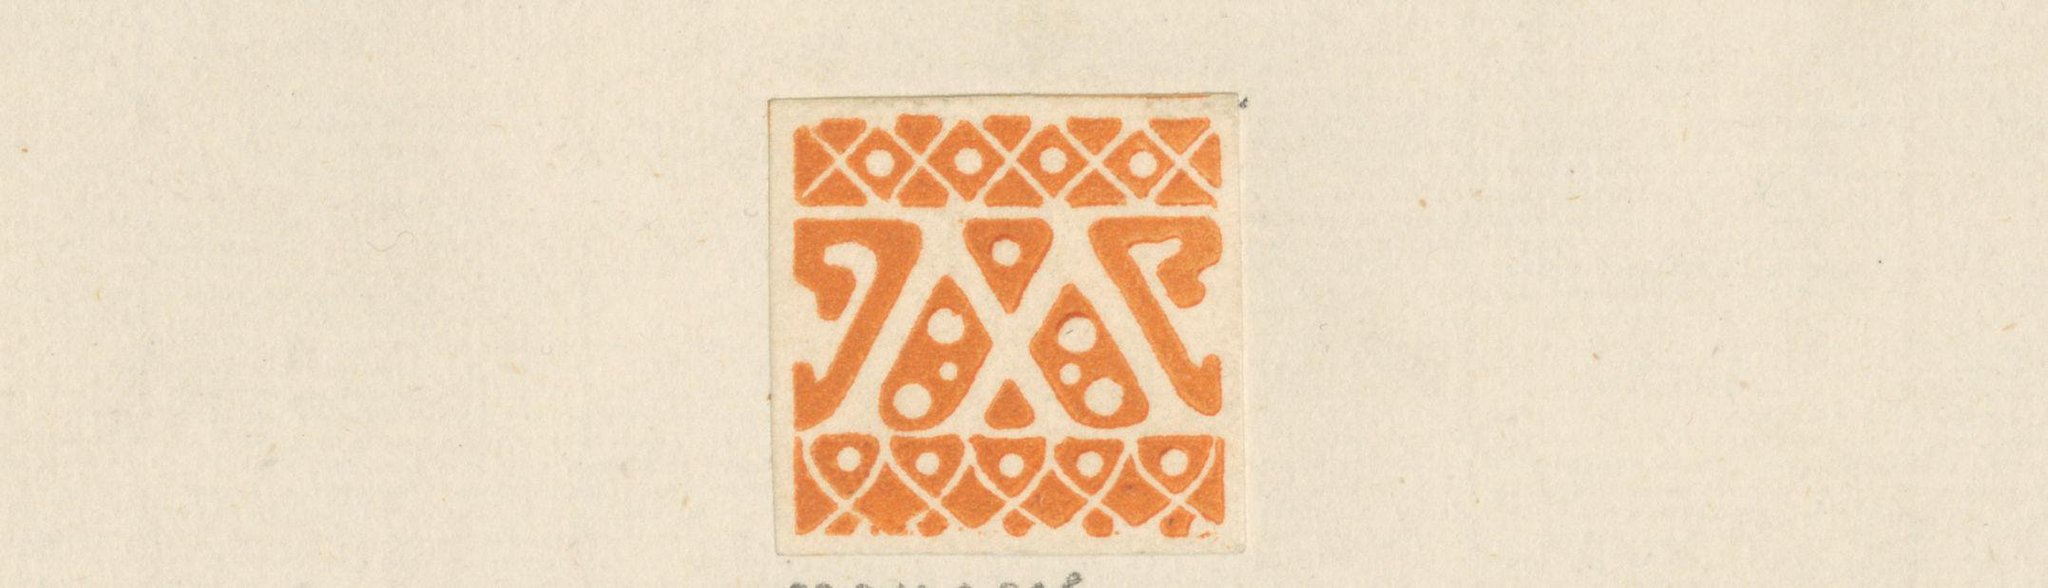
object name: bookplate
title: Ex libris van W.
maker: Anonymous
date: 1850-1950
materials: paper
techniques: printing block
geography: netherlands